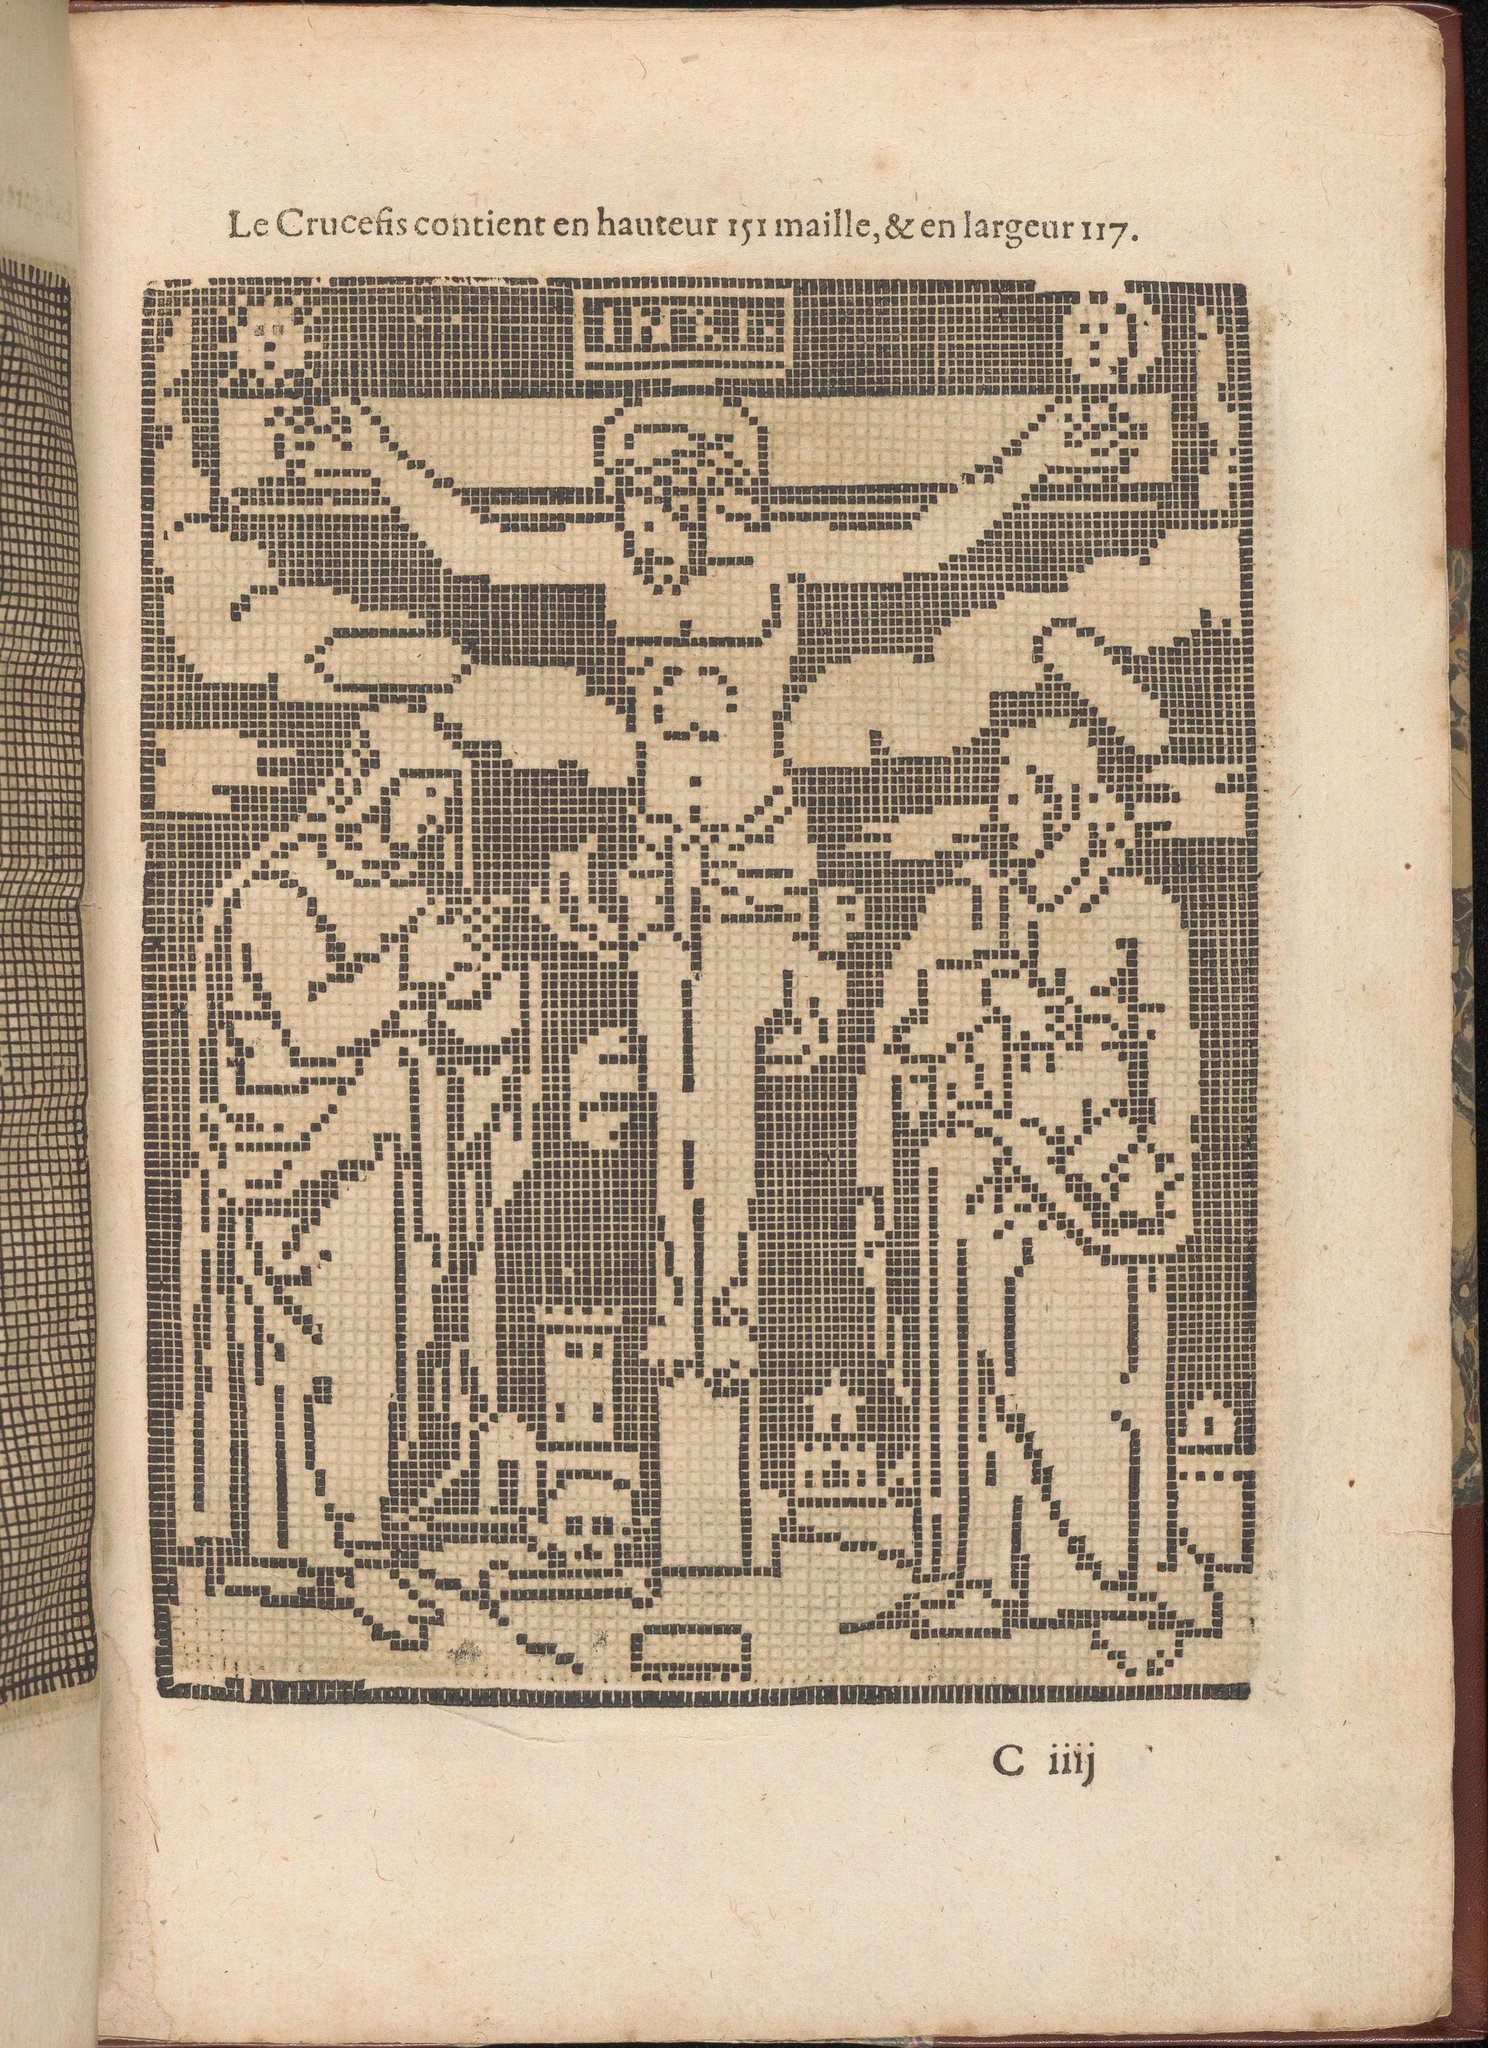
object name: book print ornament architecture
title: Les Secondes Oeuvres, et Subtiles Inventions De Lingerie du Seigneur Federic de Vinciolo Venitien, page 12 (recto)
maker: federico de vinciolo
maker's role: designer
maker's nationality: italian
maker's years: 1582-1599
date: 1603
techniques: woodcut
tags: christ,virgin mary,crucifixion,saints